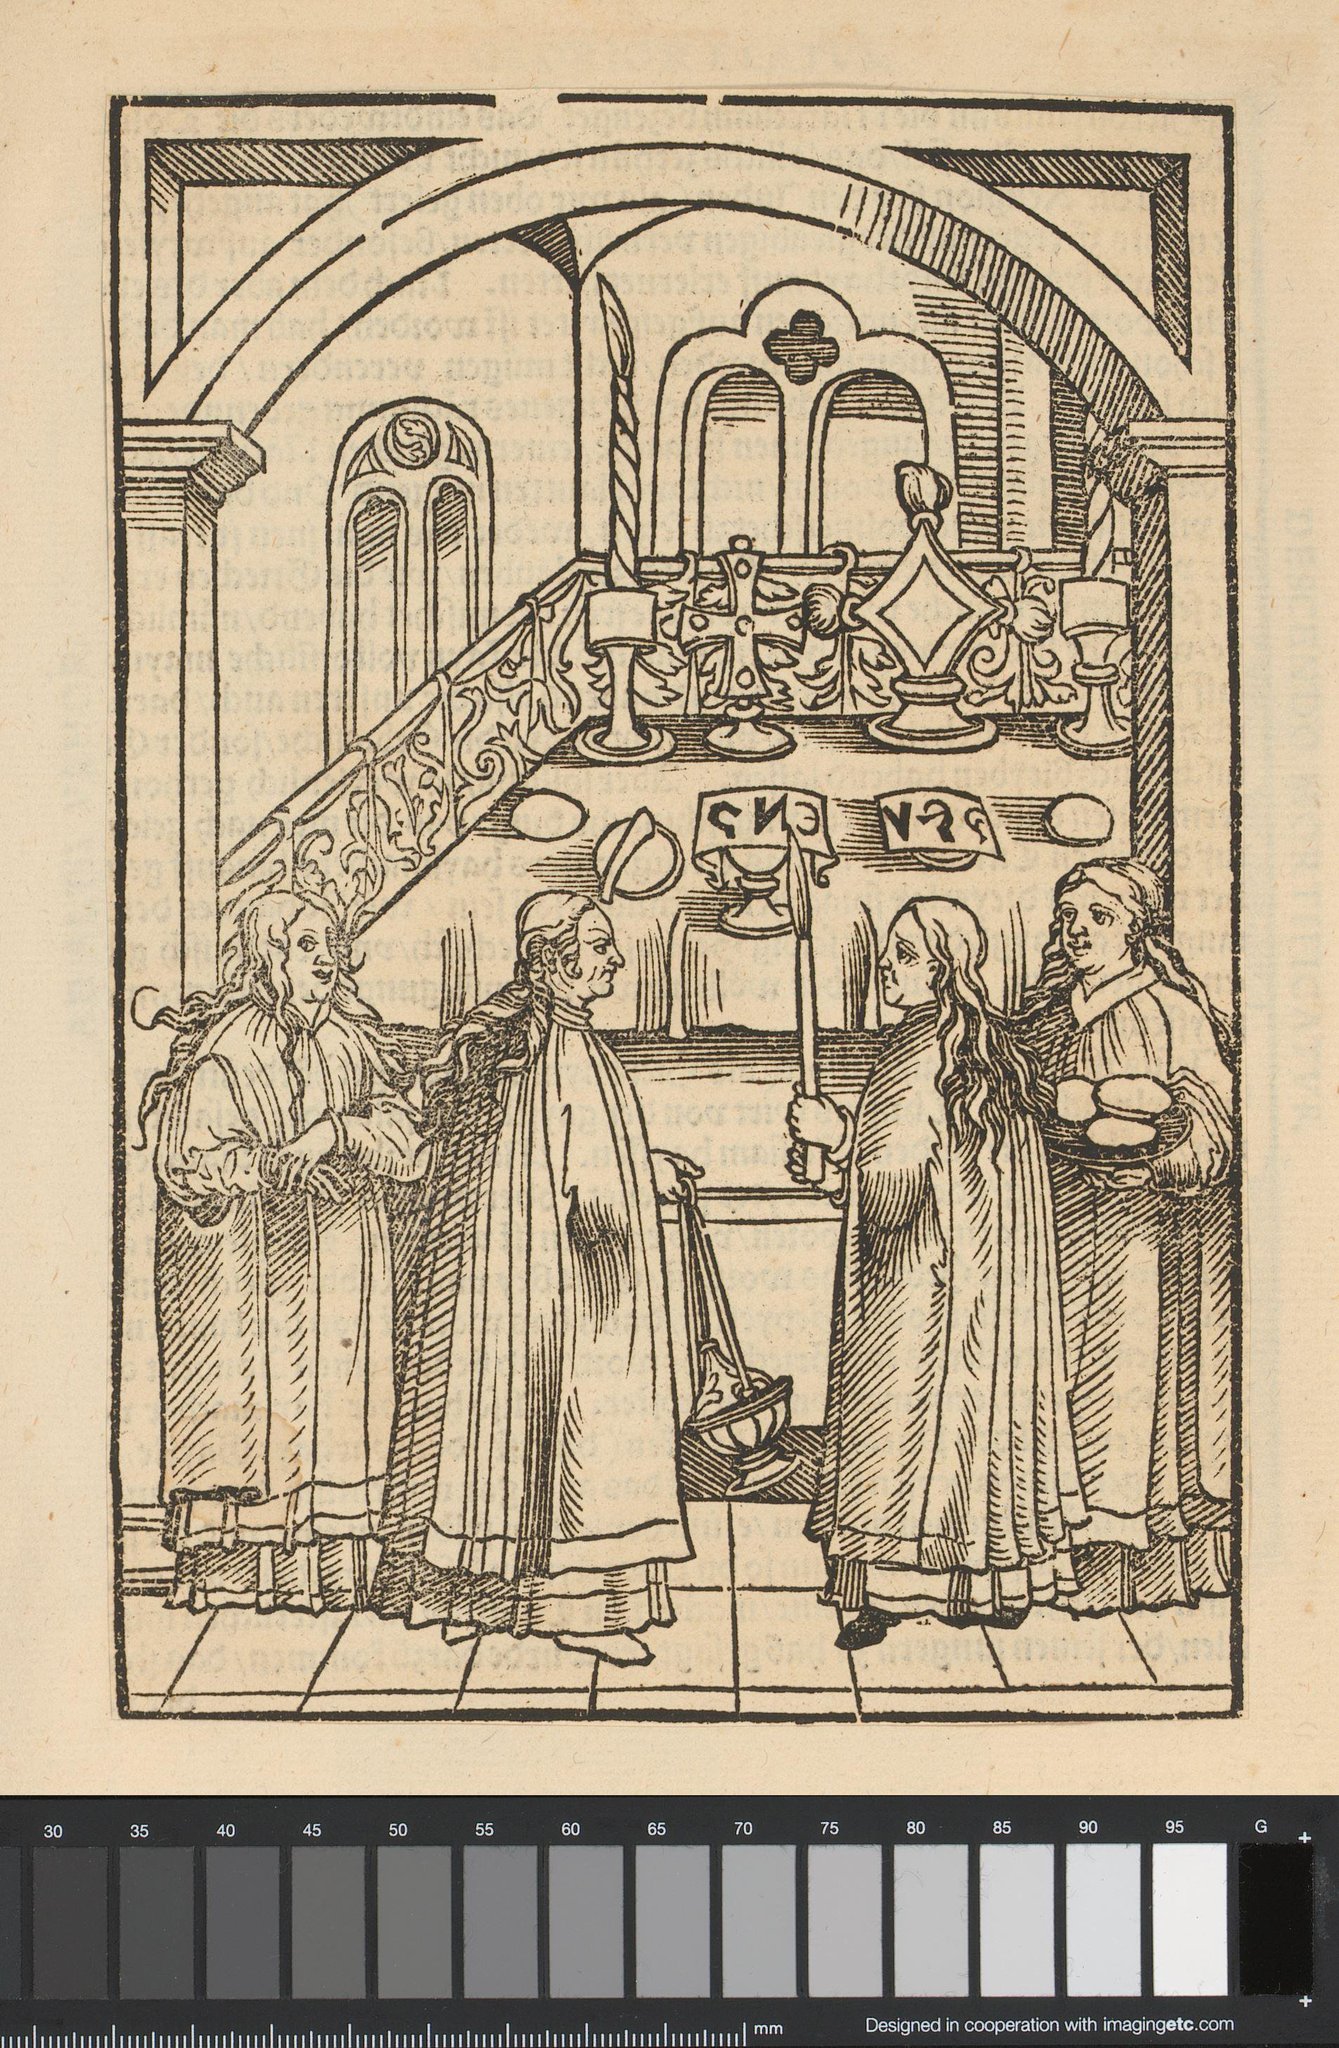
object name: print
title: Geestelijken bij een altaar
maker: Anonymous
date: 1490-1536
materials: paper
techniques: letterpress printing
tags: censer, holy mass (divine service, especially of roman catholic church)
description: Prent is gebruikt in: Reichenthal, Ulrich von. Reichenthal Das Concilium so zu Constantz Gehalten ist Worden (...). Augsburg: Heinrich Steiner, 1536.